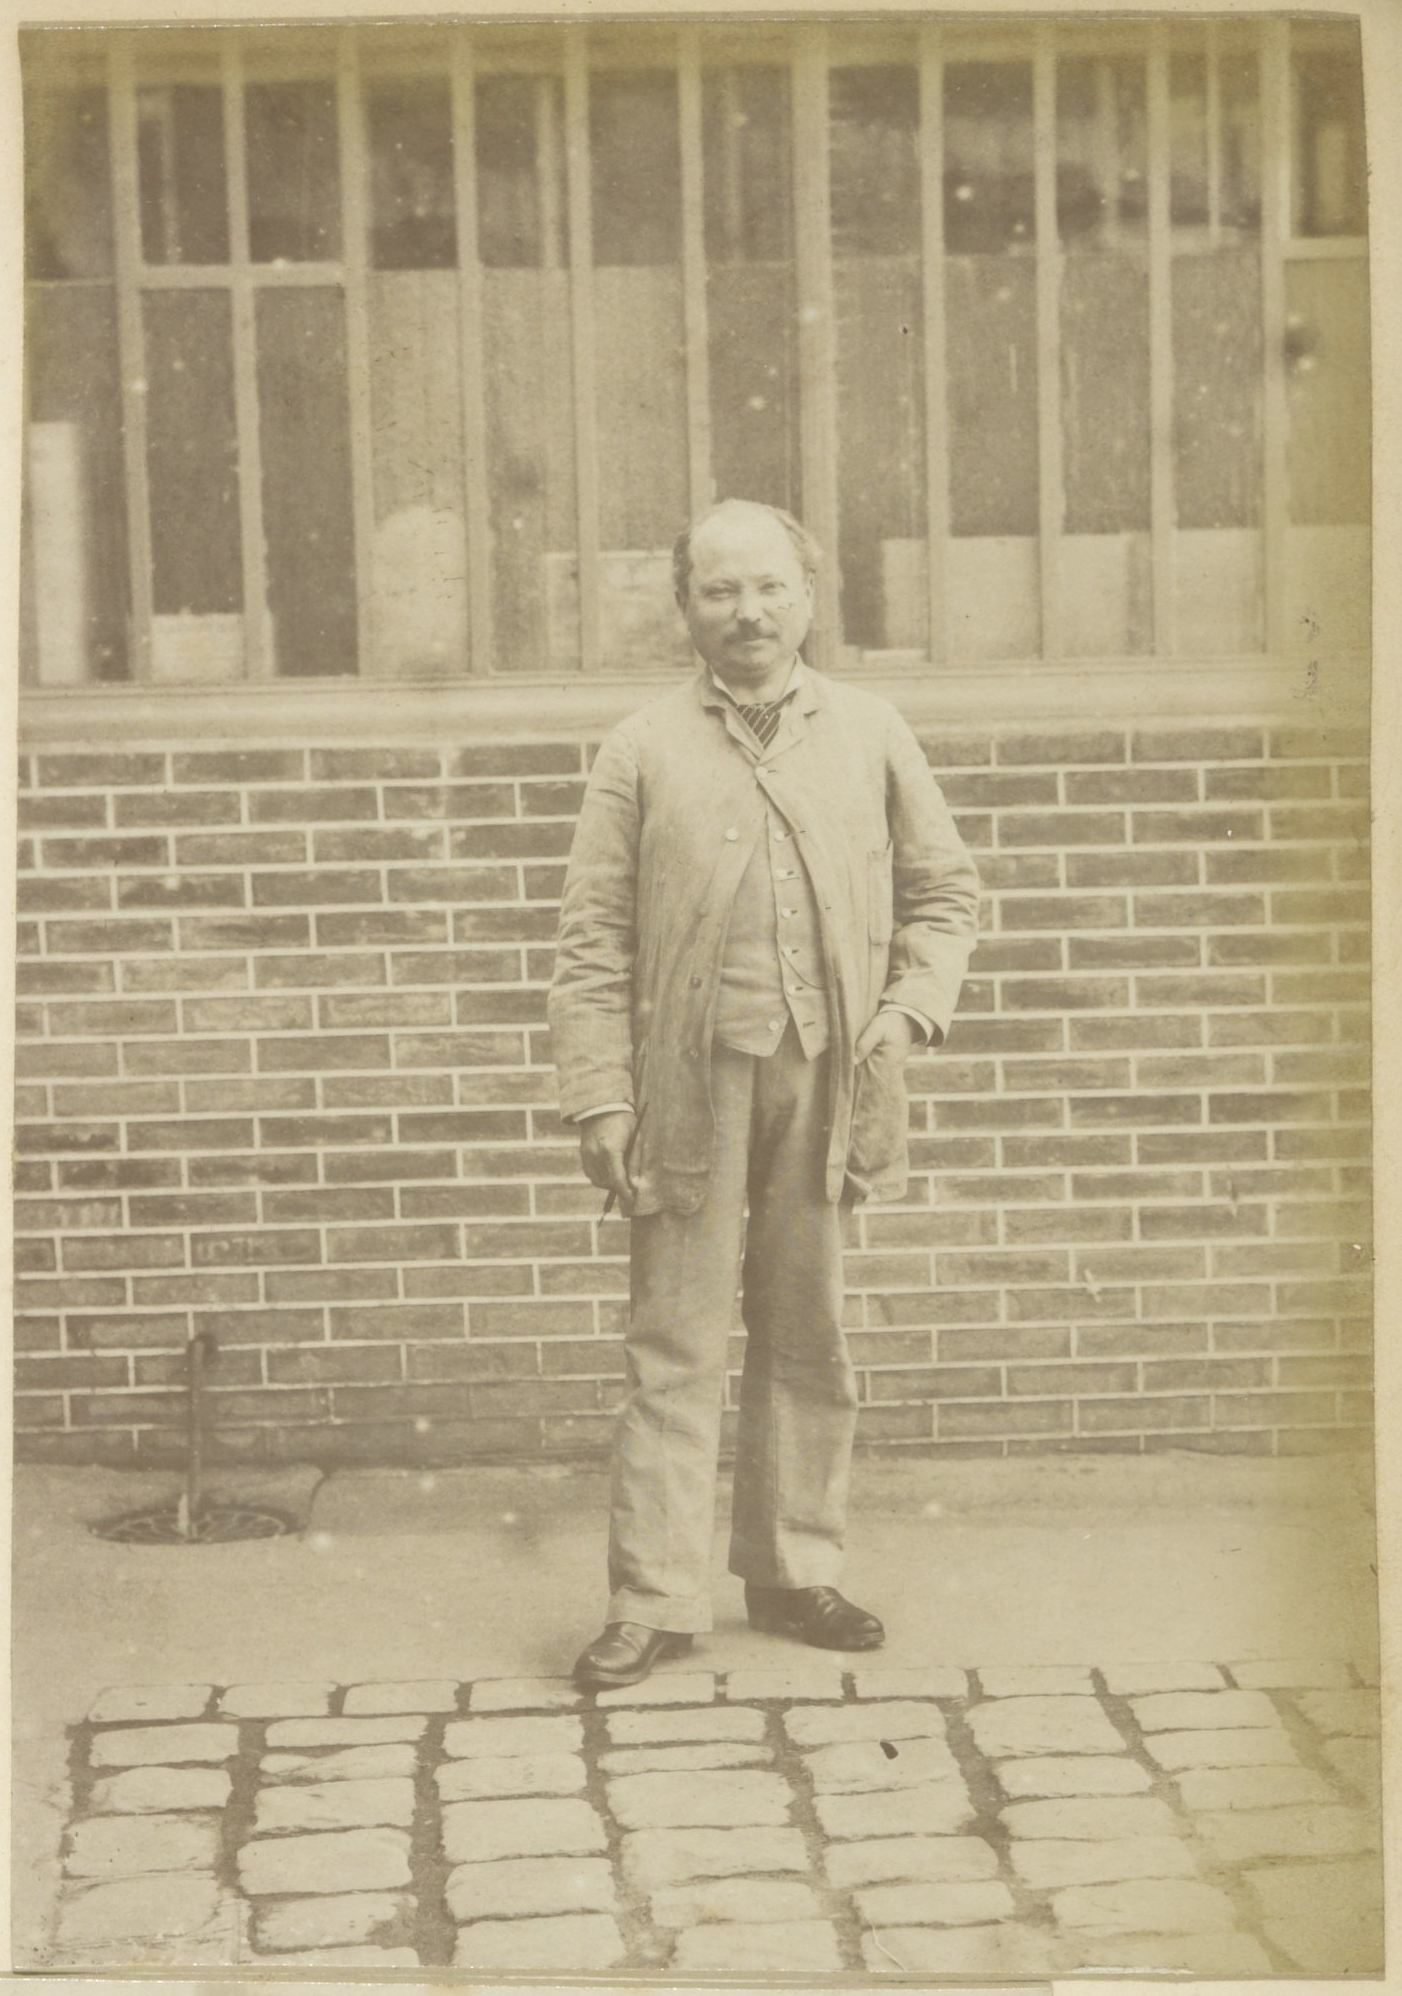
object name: photograph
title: Portret van een man in een korte overjas, mogelijk een werknemer van distilleerderij Delizy & Doisteau in Pantin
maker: Anonymous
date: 1900-1910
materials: paper, photographic support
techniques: albumen print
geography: pantin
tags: adult man, coat, cape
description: Onderdeel van Fotoalbum van een Franse amateurfotograaf met opnames van een familie, distilleerderij Delizy & Doistau Fils, het leger en bezienswaardigheden in Frankrijk.